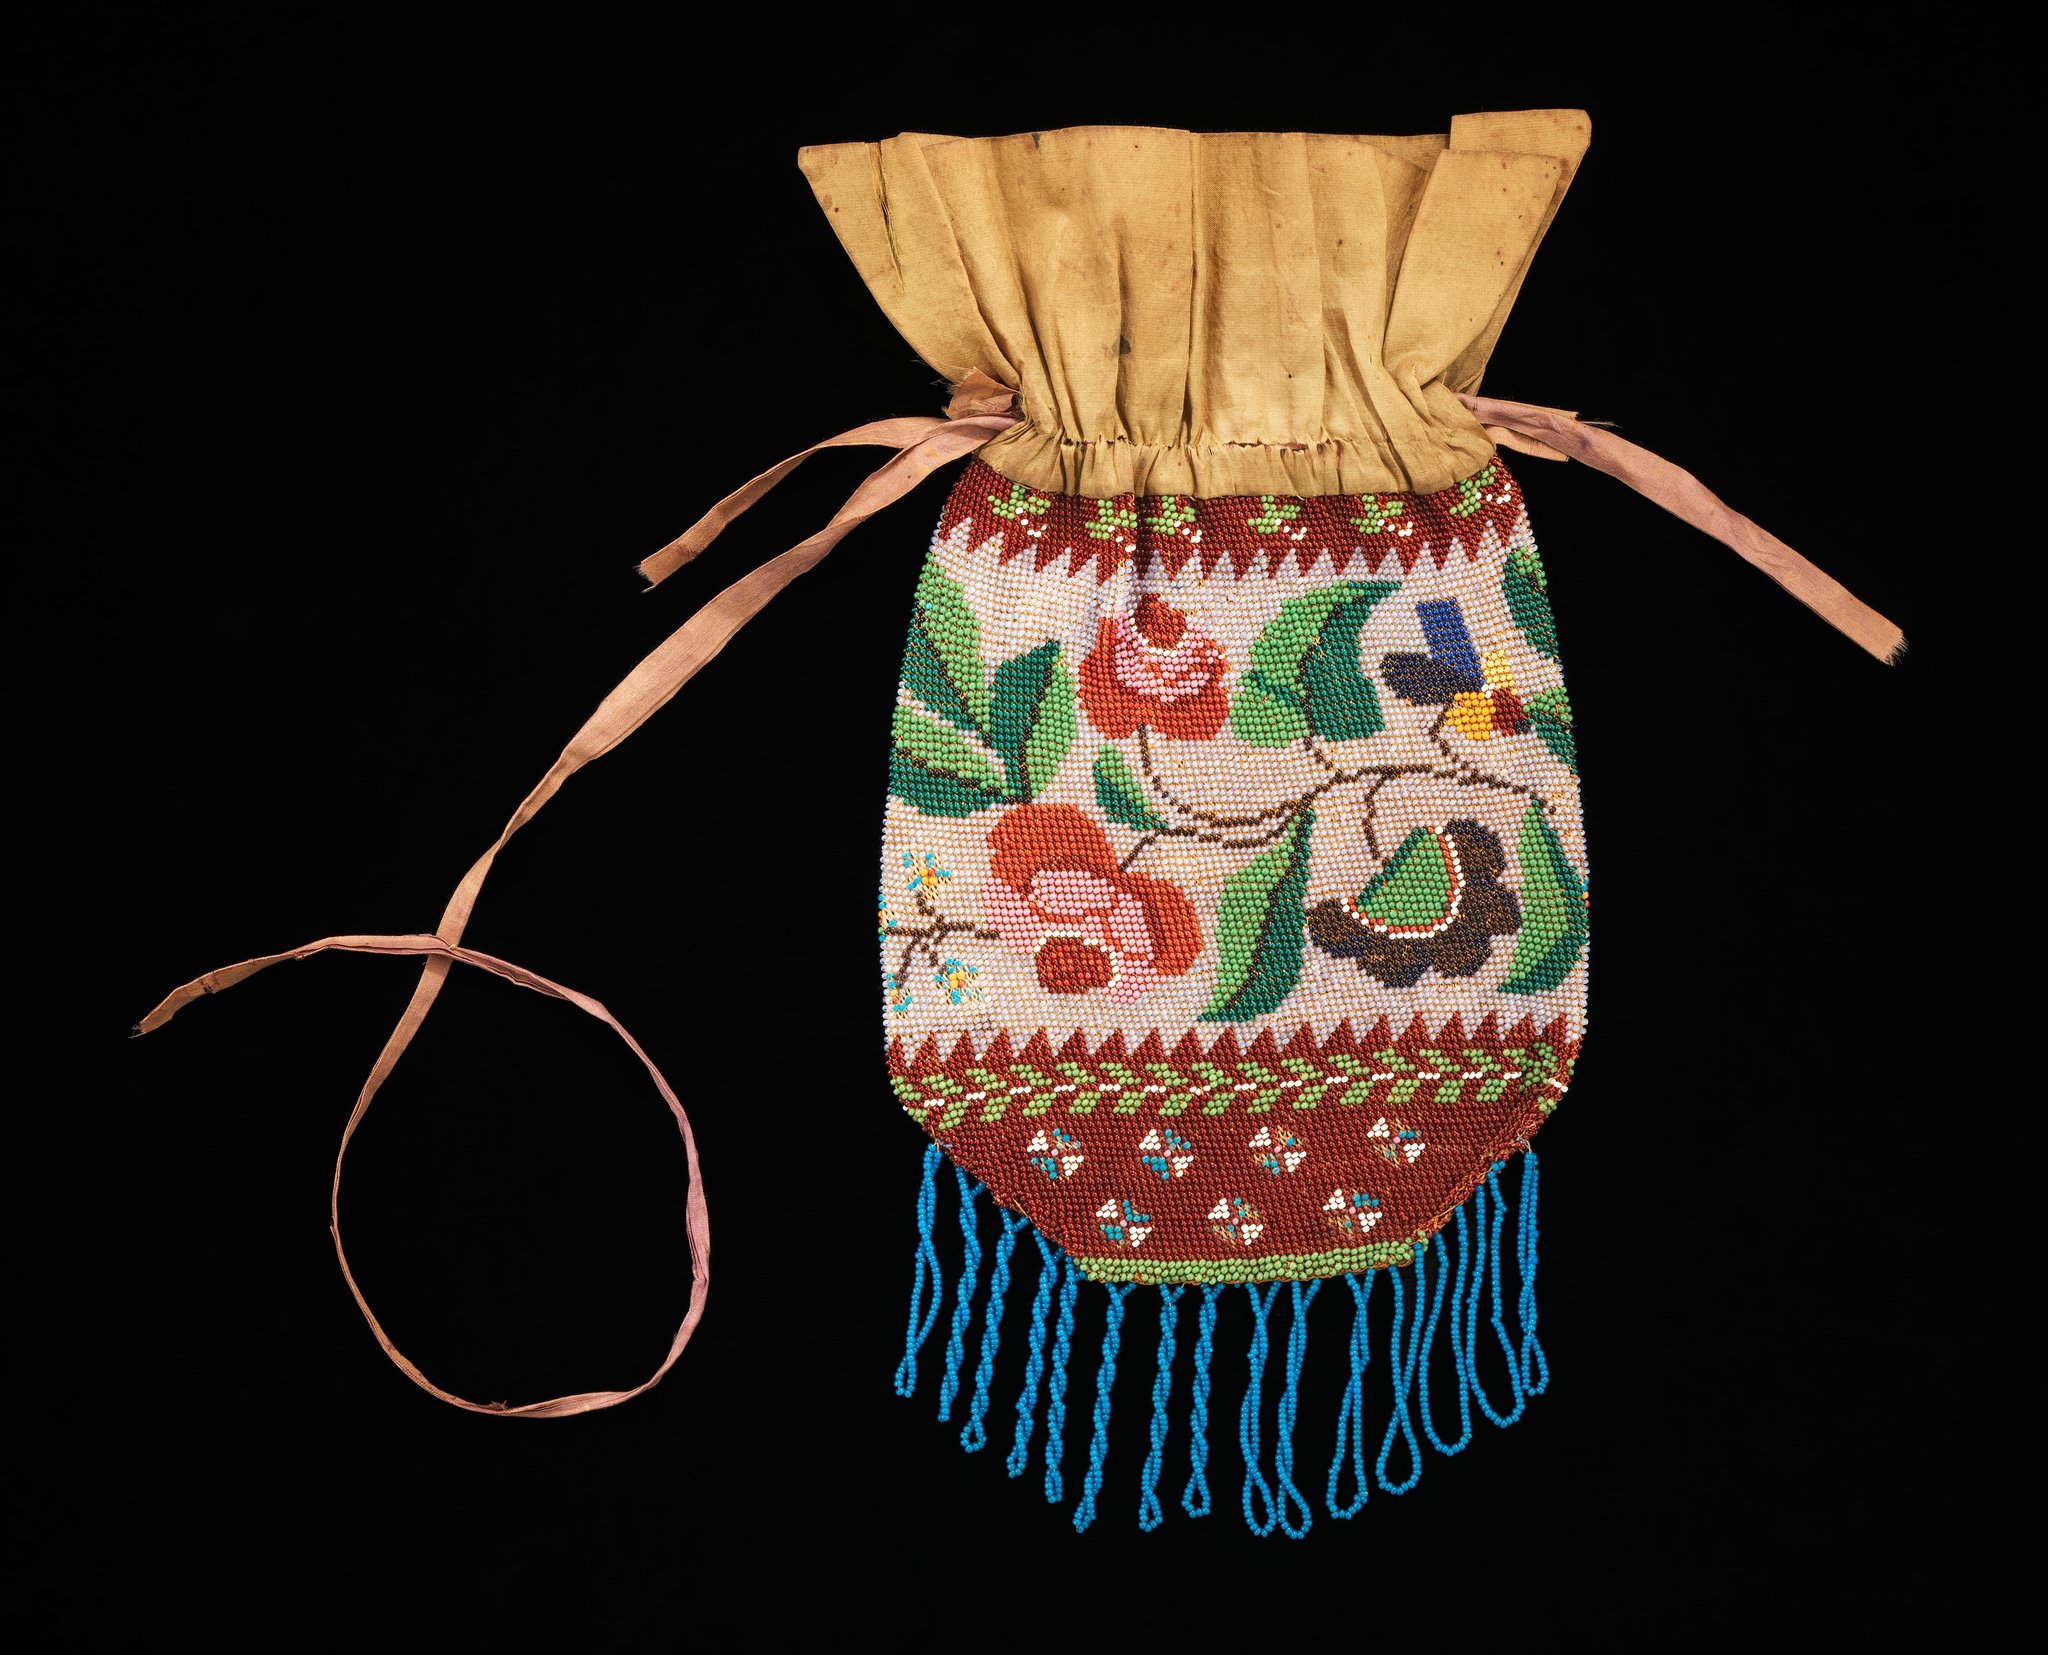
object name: pouch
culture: american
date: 1830-1860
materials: glass, linen, silk